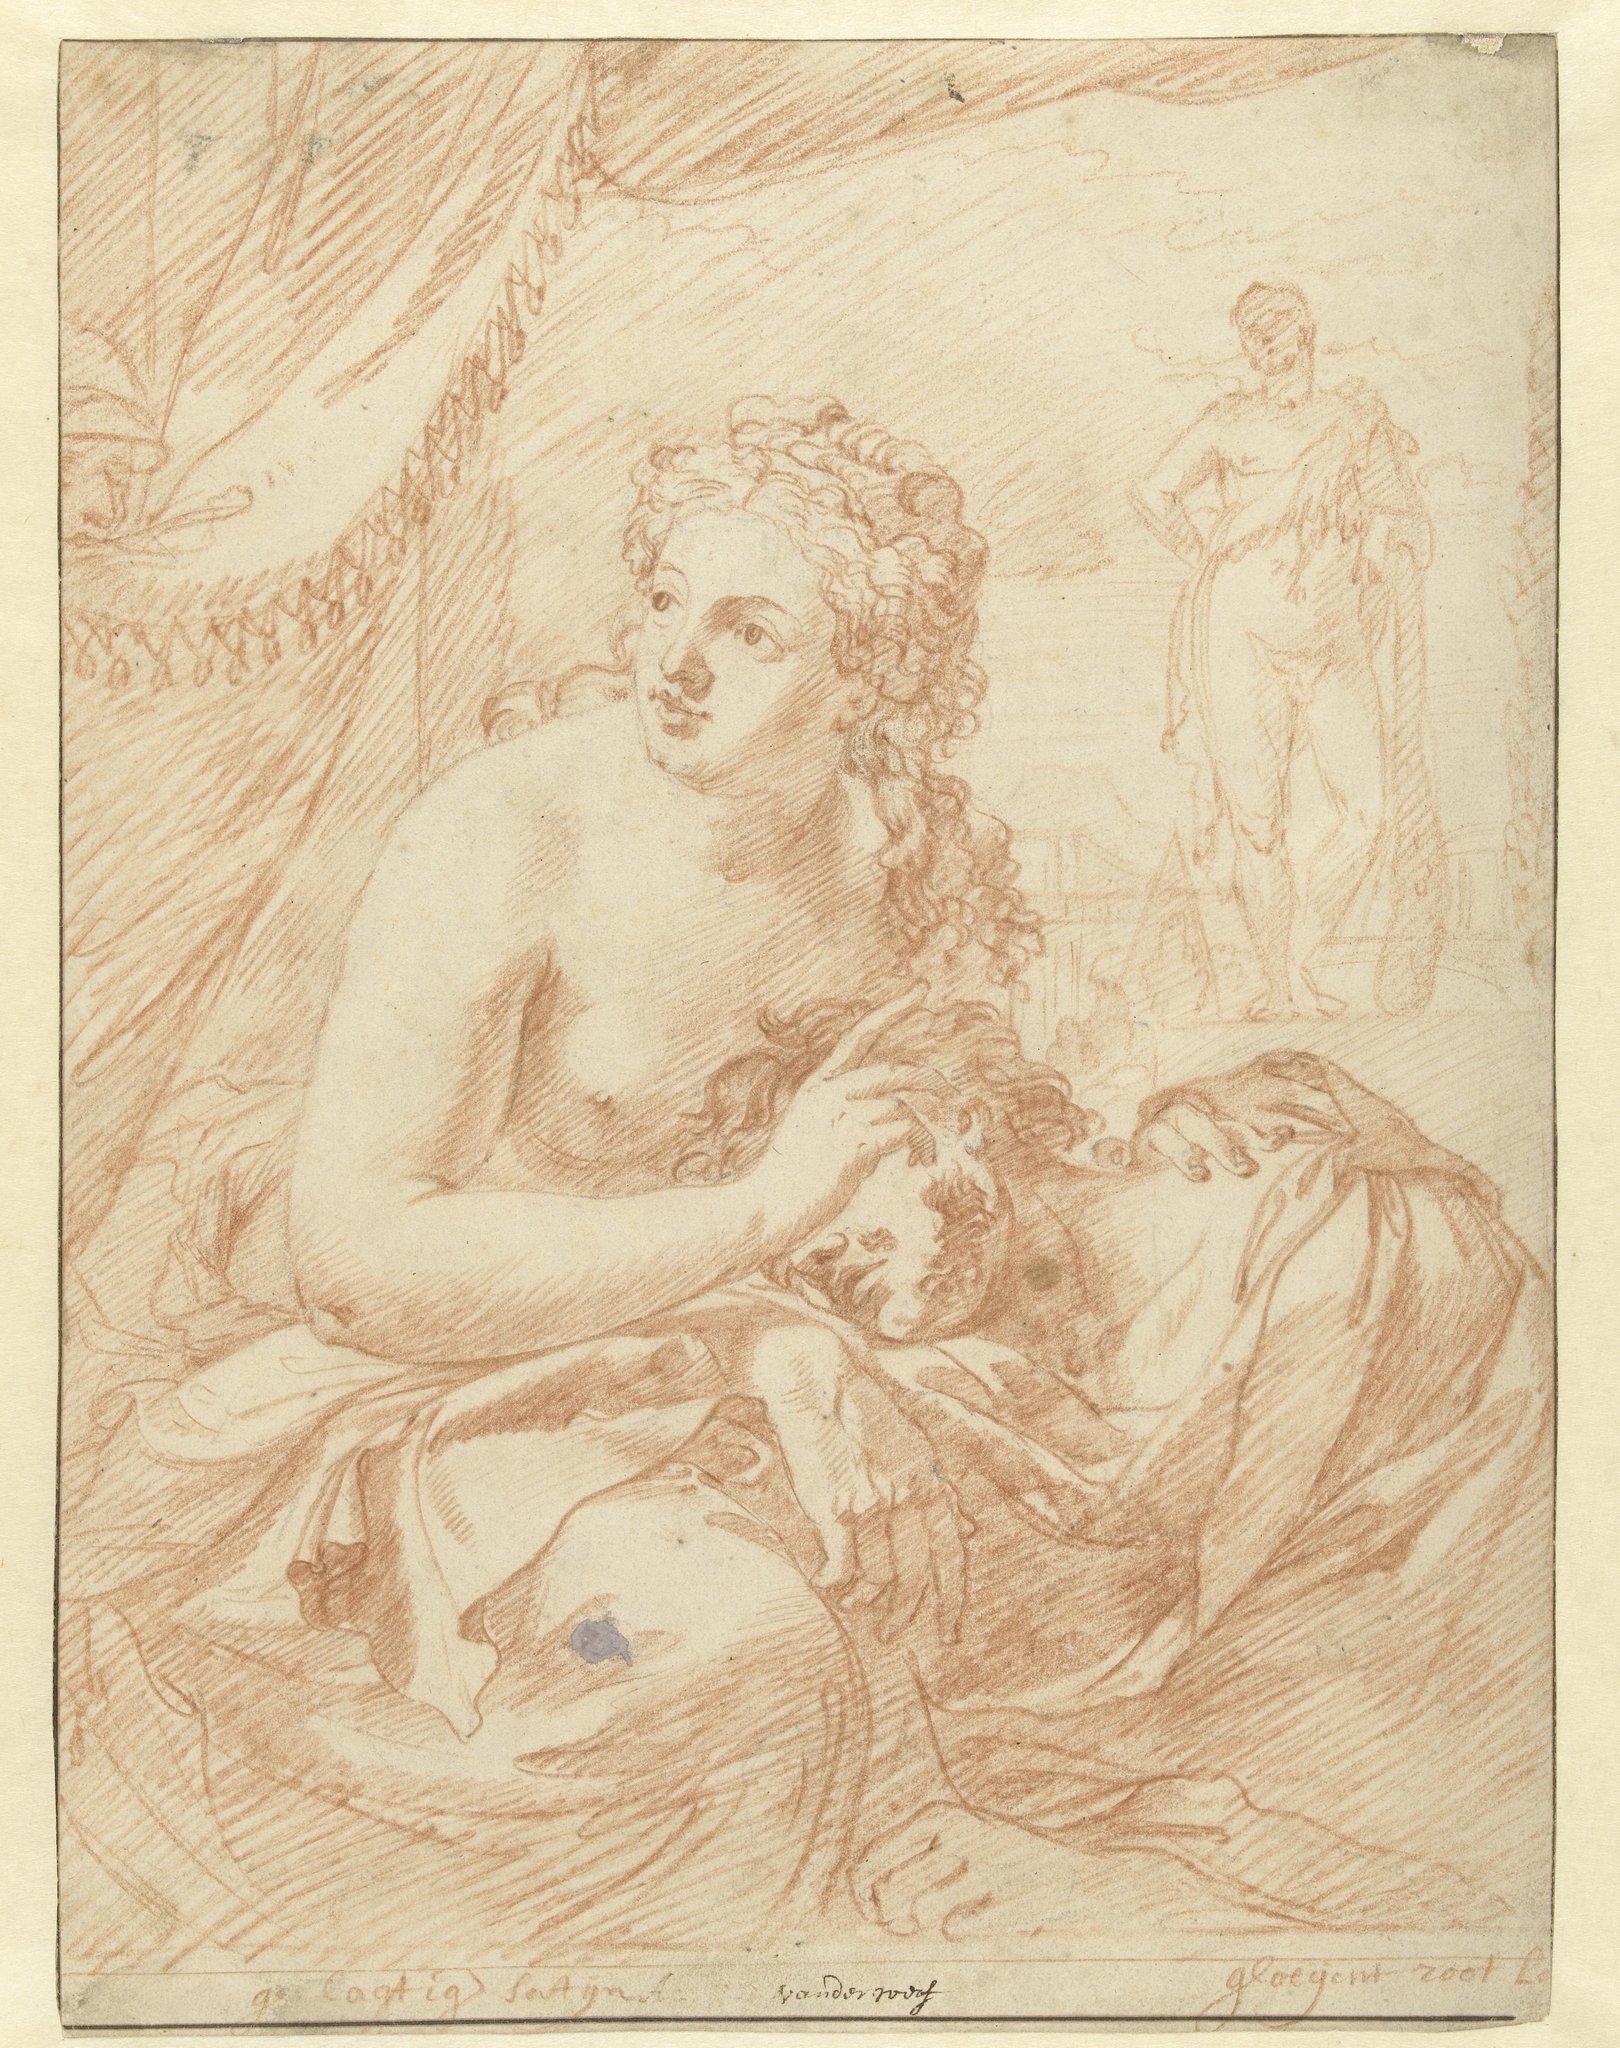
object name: drawing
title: Samson en Delila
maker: adriaen van der werff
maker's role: draughtsman, painter, print maker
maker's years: 1659-1722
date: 1669-1722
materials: chalk, paper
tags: samson asleep in delilah's lap; she is usually shown beckoning to a philistine or putting a finger to her lips